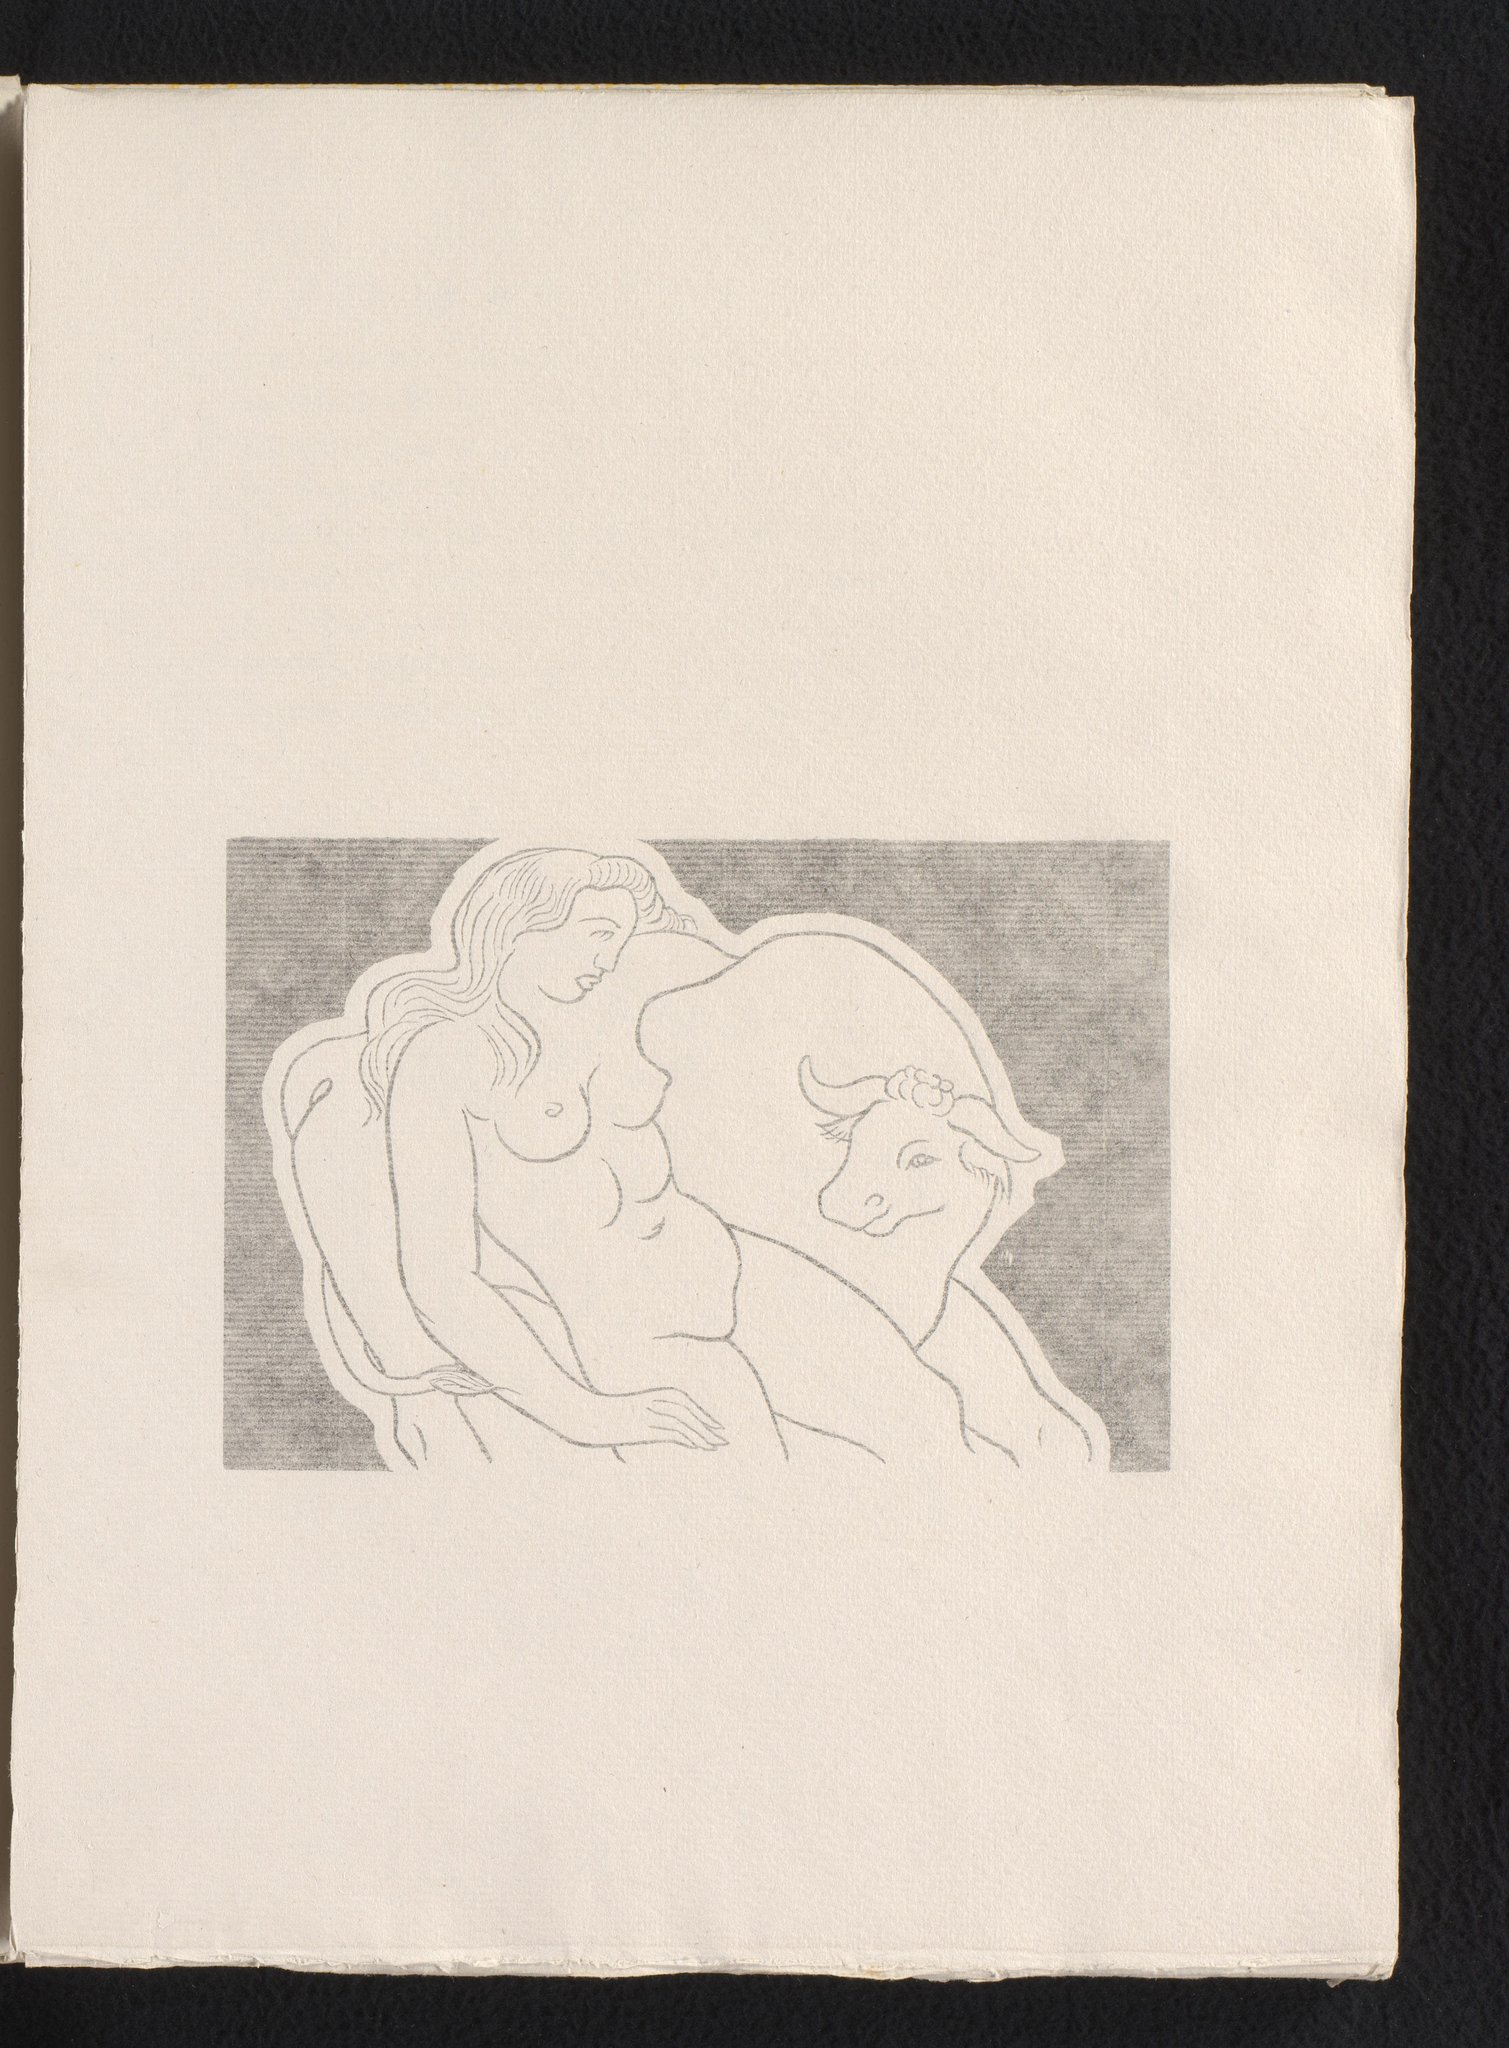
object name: print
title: Pasiphaë en de witte stier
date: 1935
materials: paper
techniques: woodcut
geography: lausanne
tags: bull, pasiphae enamoured of a white bull, woman (showing herself) undressed, quasi-nude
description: Prent in: Ovidius Naso, Publius. L'art d'aimer. [Vertaald uit het Latijn door] Henri Bornecque. Parijs/Lausanne: Les frères Gonin, 1935, voor p. 21. Deze zelfde afbeelding is nogmaals gebruikt op pagina 21.